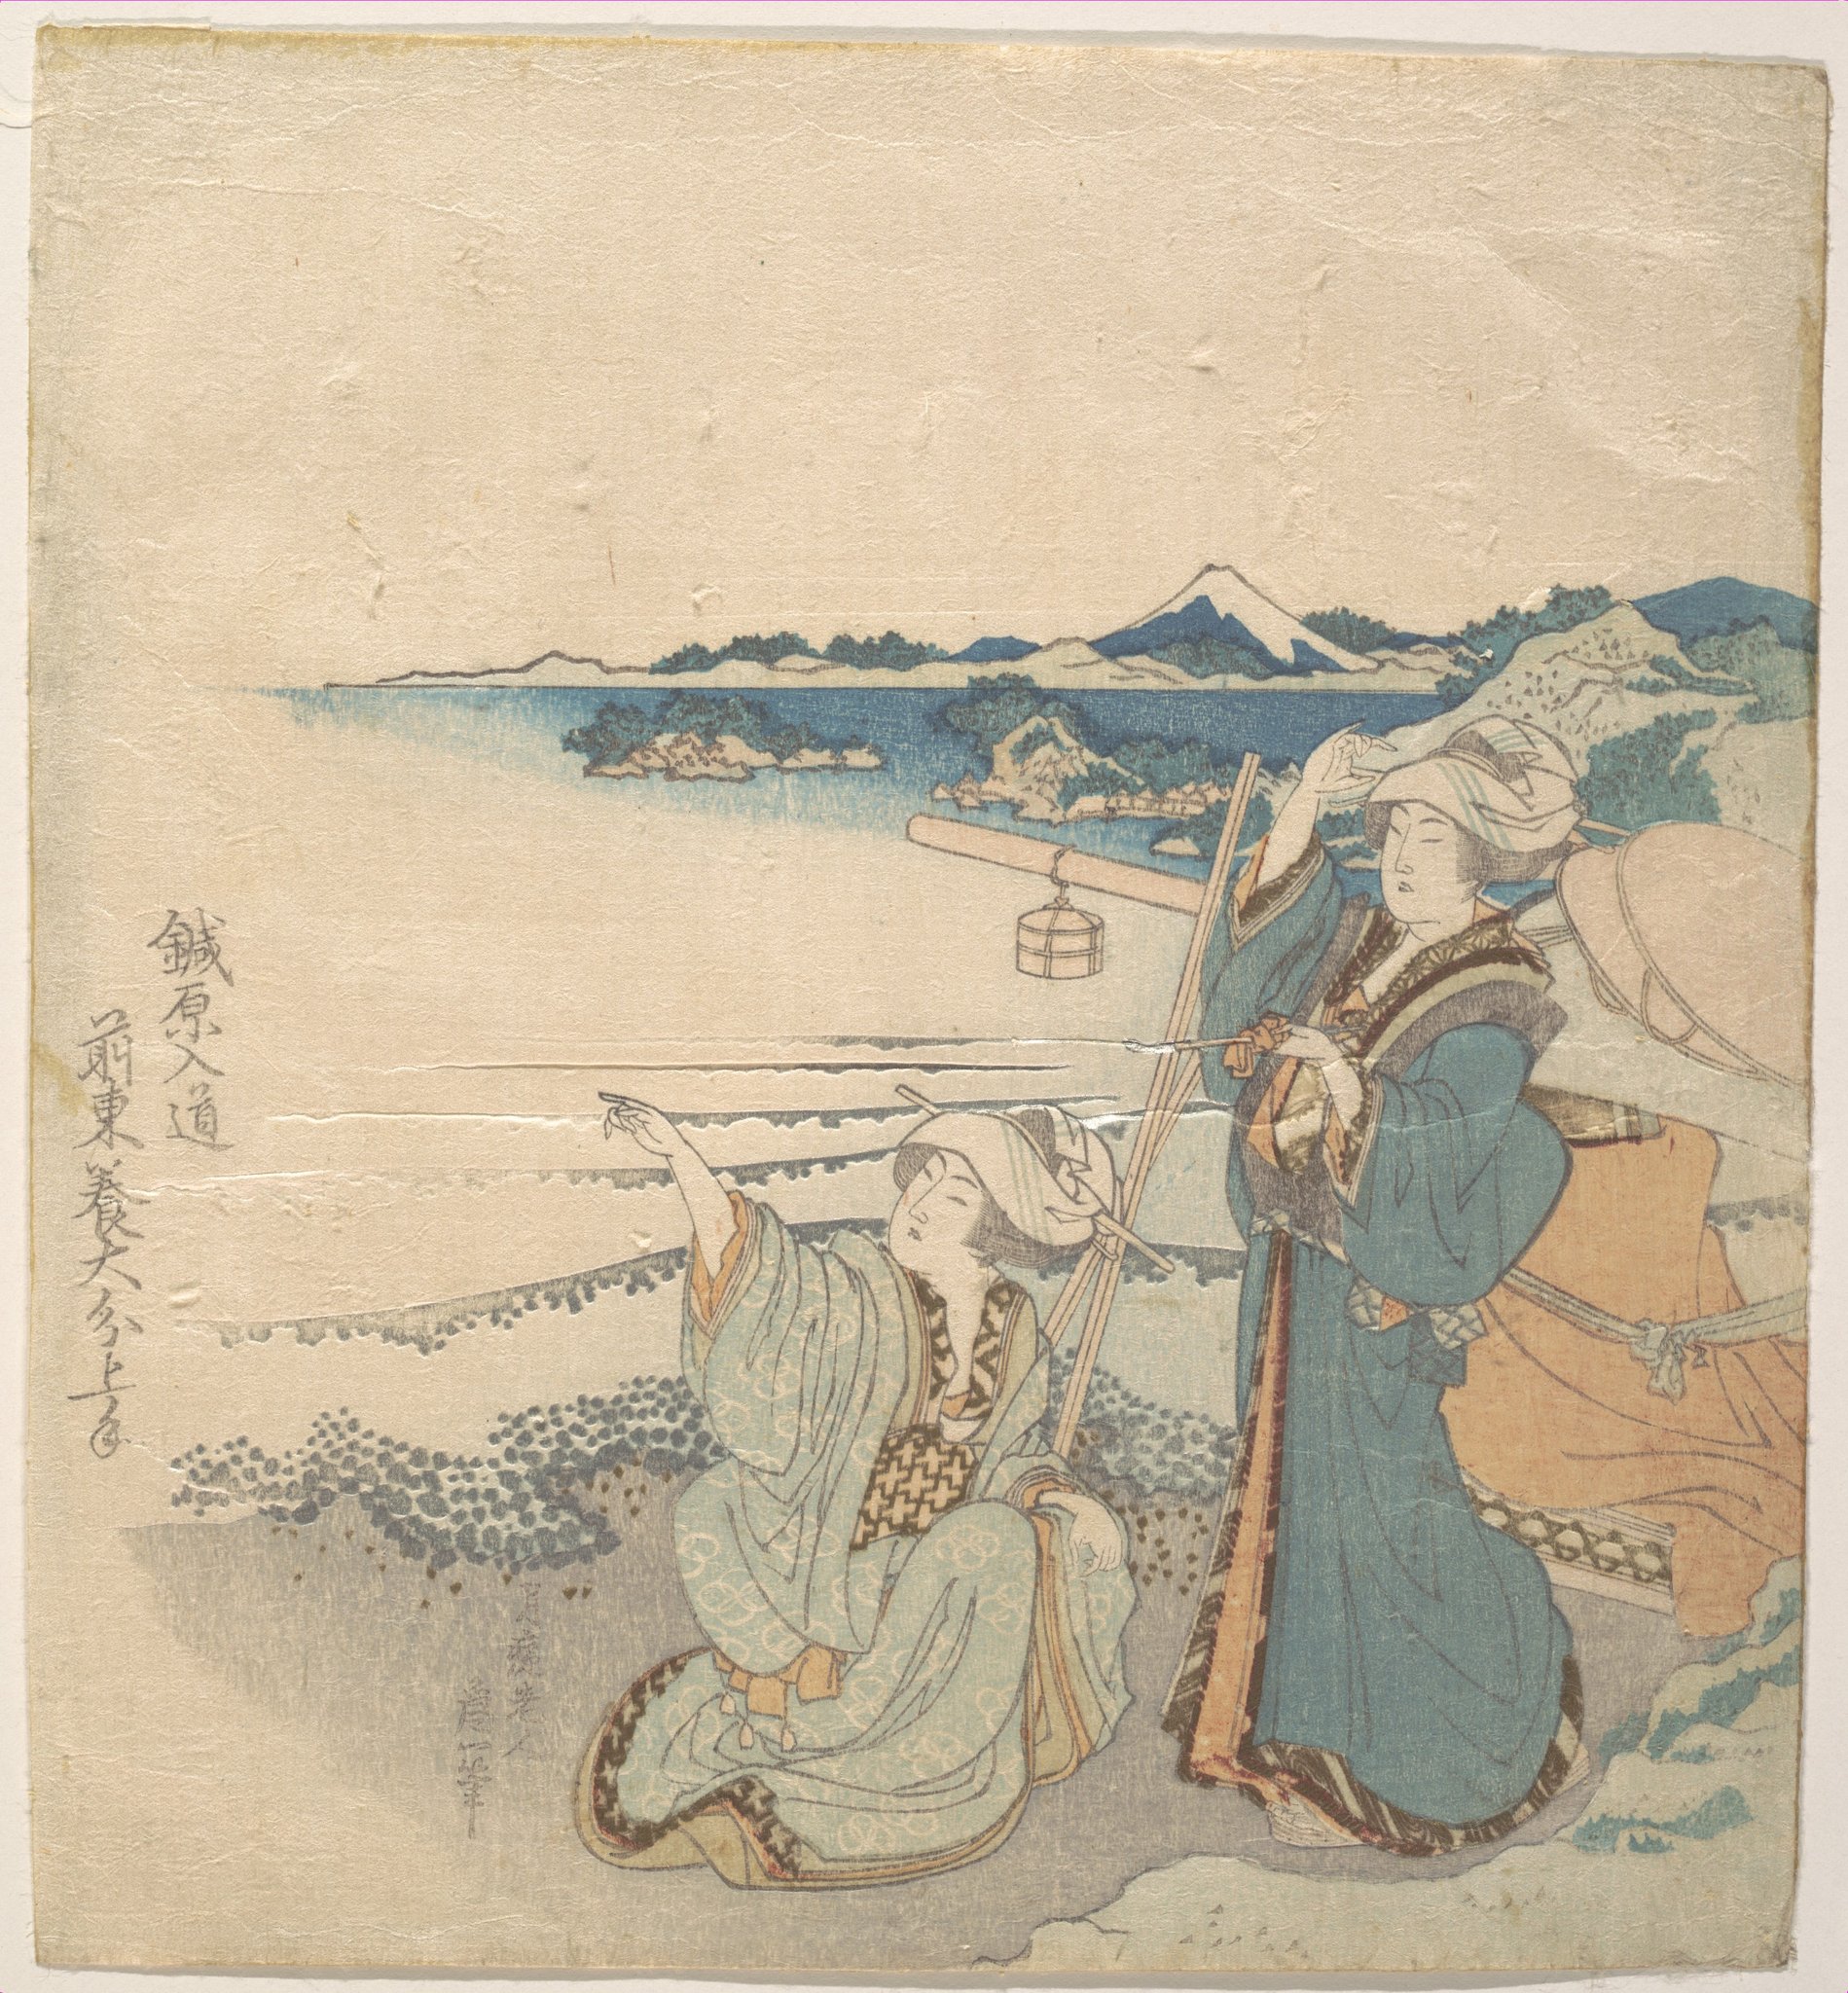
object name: print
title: Two Young Ladies at Shore; One Pointing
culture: japanese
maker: katsushika hokusai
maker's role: artist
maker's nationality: japanese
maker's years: 1760-1849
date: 1760-1849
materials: ink, paper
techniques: surimono, woodblock print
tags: women,landscapes